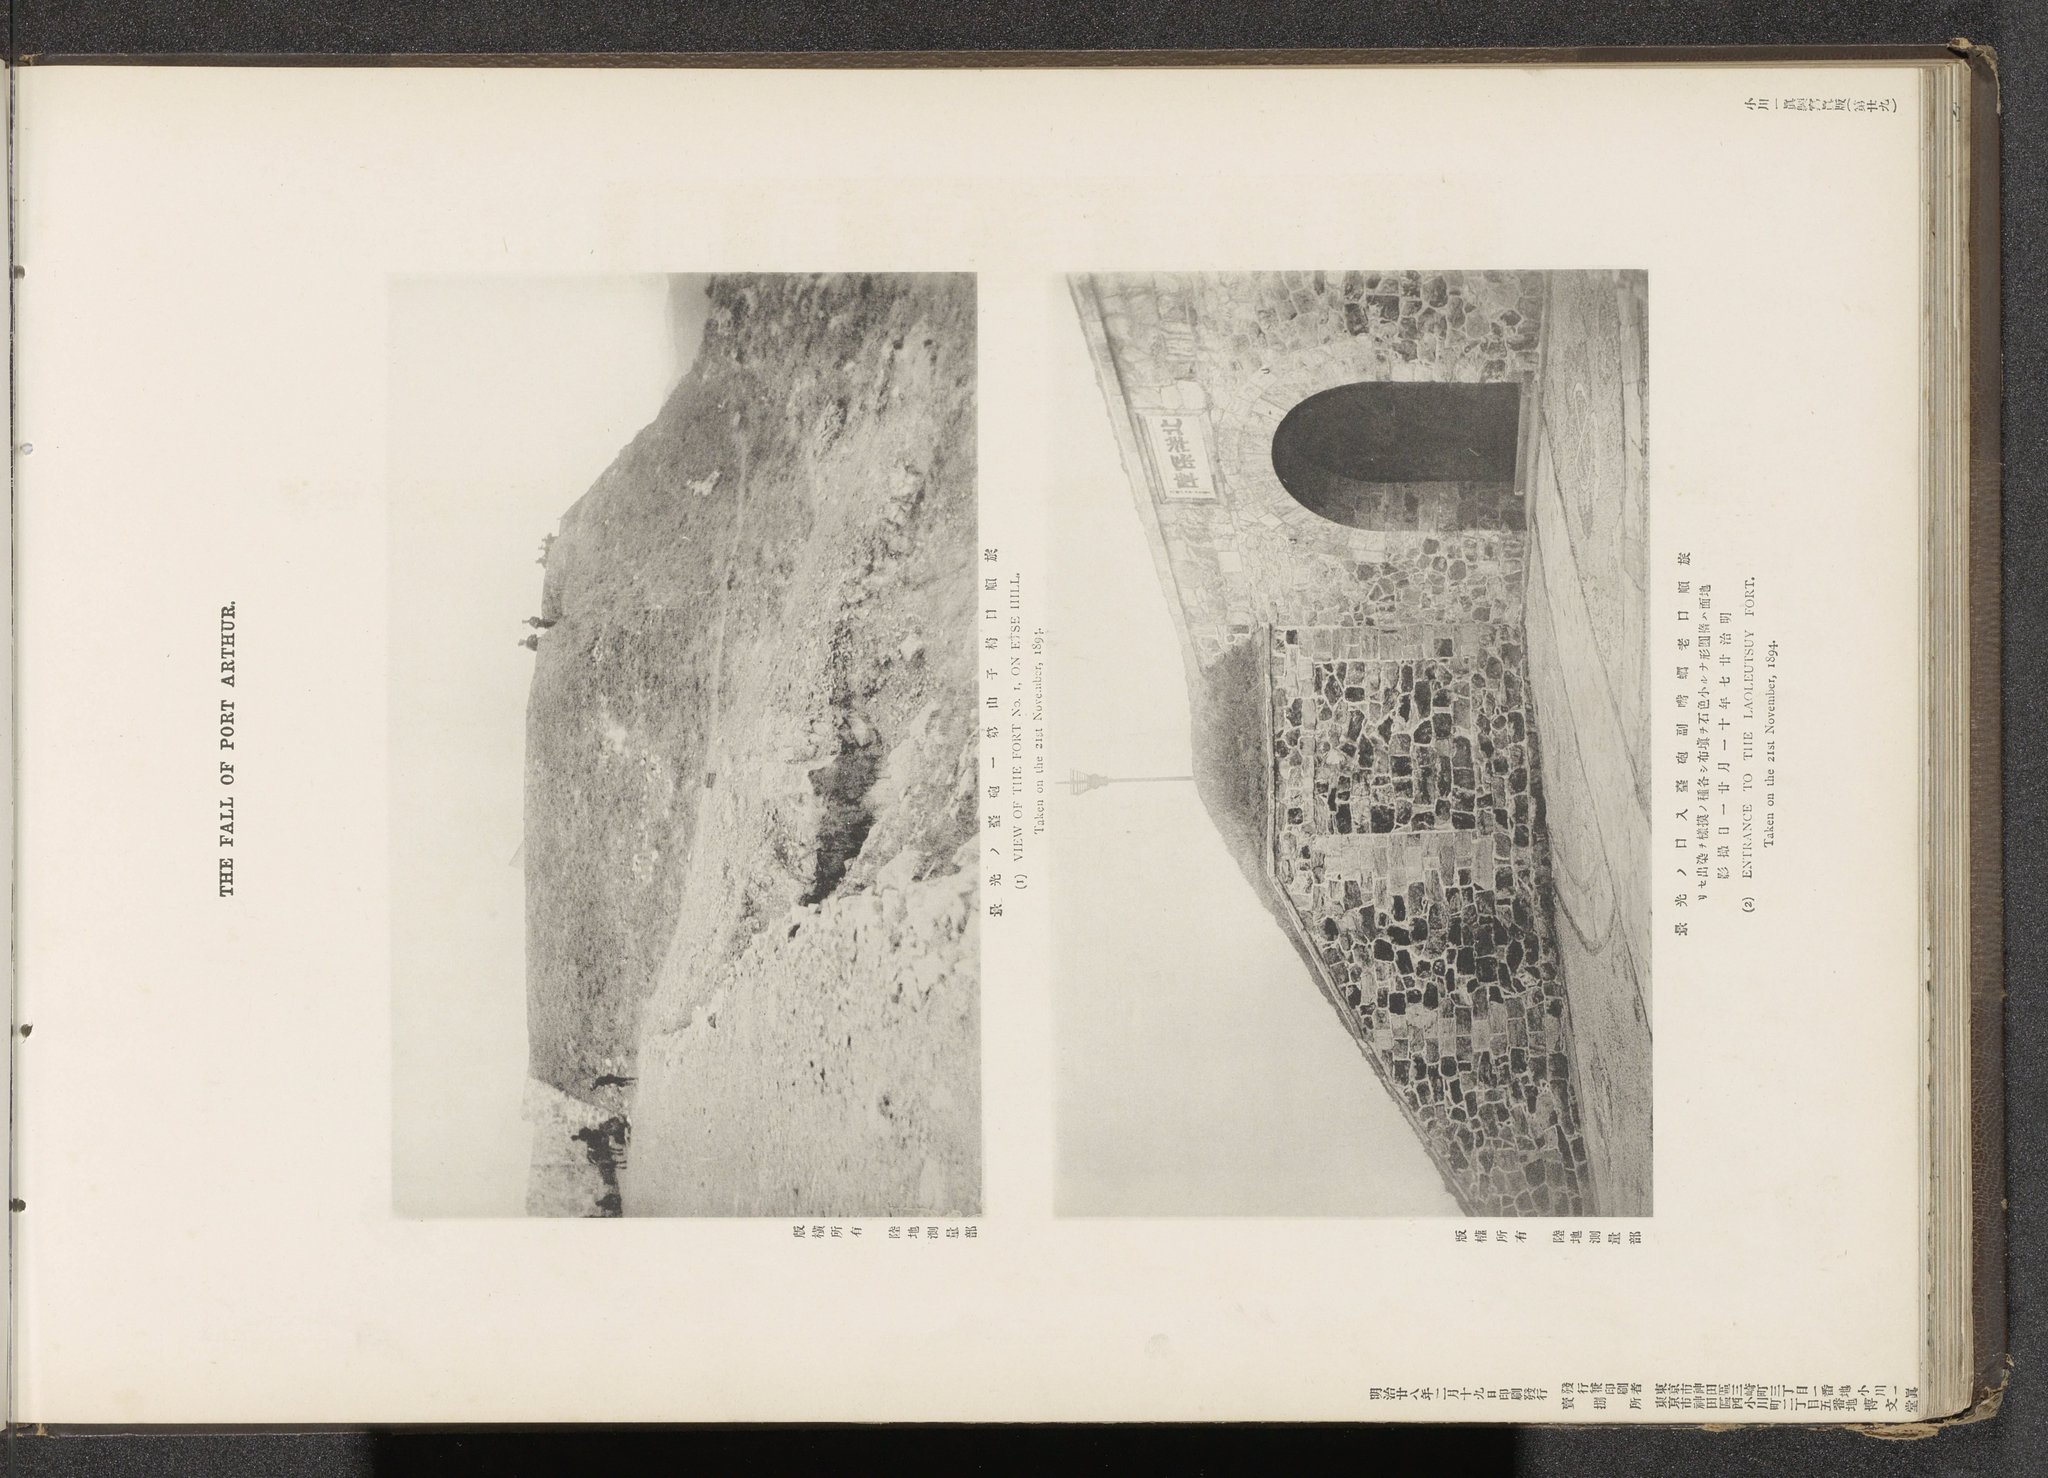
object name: page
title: Twee gezichten op forten te Mantsjoerije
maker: kazumasa ogawa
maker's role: auteur, fotograaf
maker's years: 1860-1929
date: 1894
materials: paper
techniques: photograph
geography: japan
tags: fortress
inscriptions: inscription: ‘The fall of Port Arthur.’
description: Boven het fort op de Etse-heuvel, onder de ingang naar het Laoleutsuy-fort.